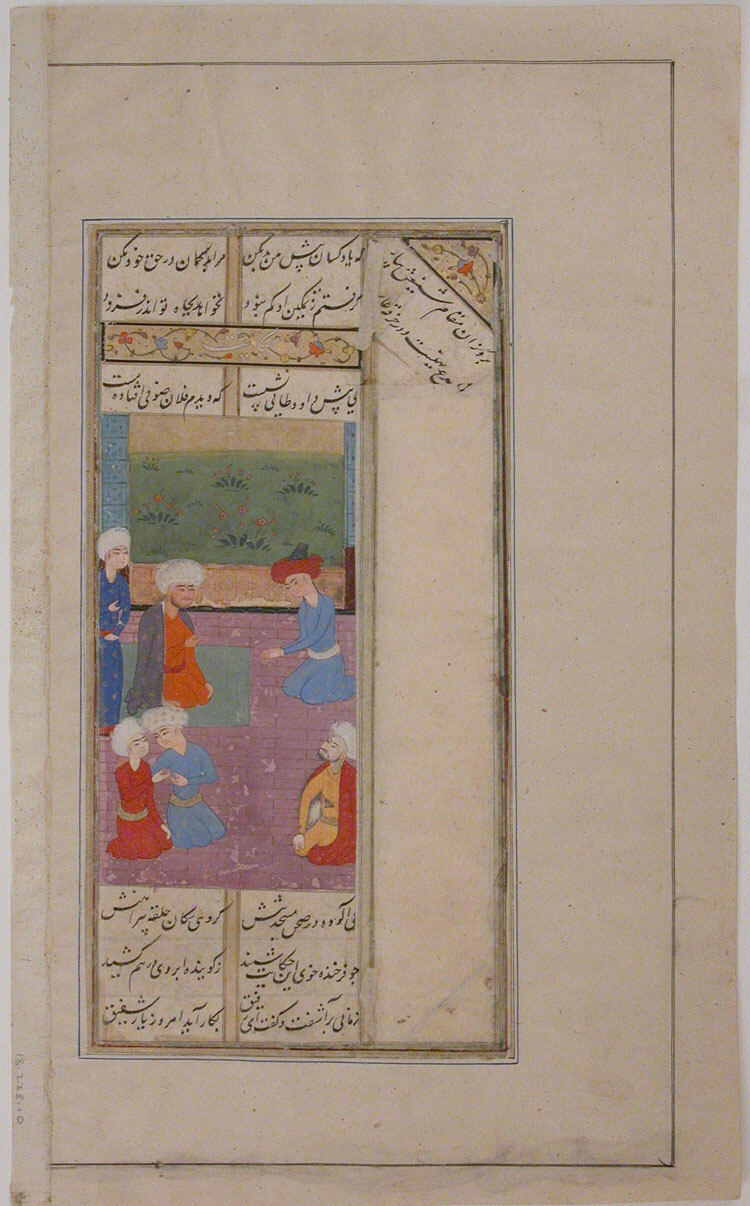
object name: folio from an illustrated manuscript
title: "A Man Complained to Da'ud of a Sufi Mystic Drunk", Folio from a Kulliyat (Complete Works) of Sa'di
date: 1801-1900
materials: gold, ink, paper, watercolor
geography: india